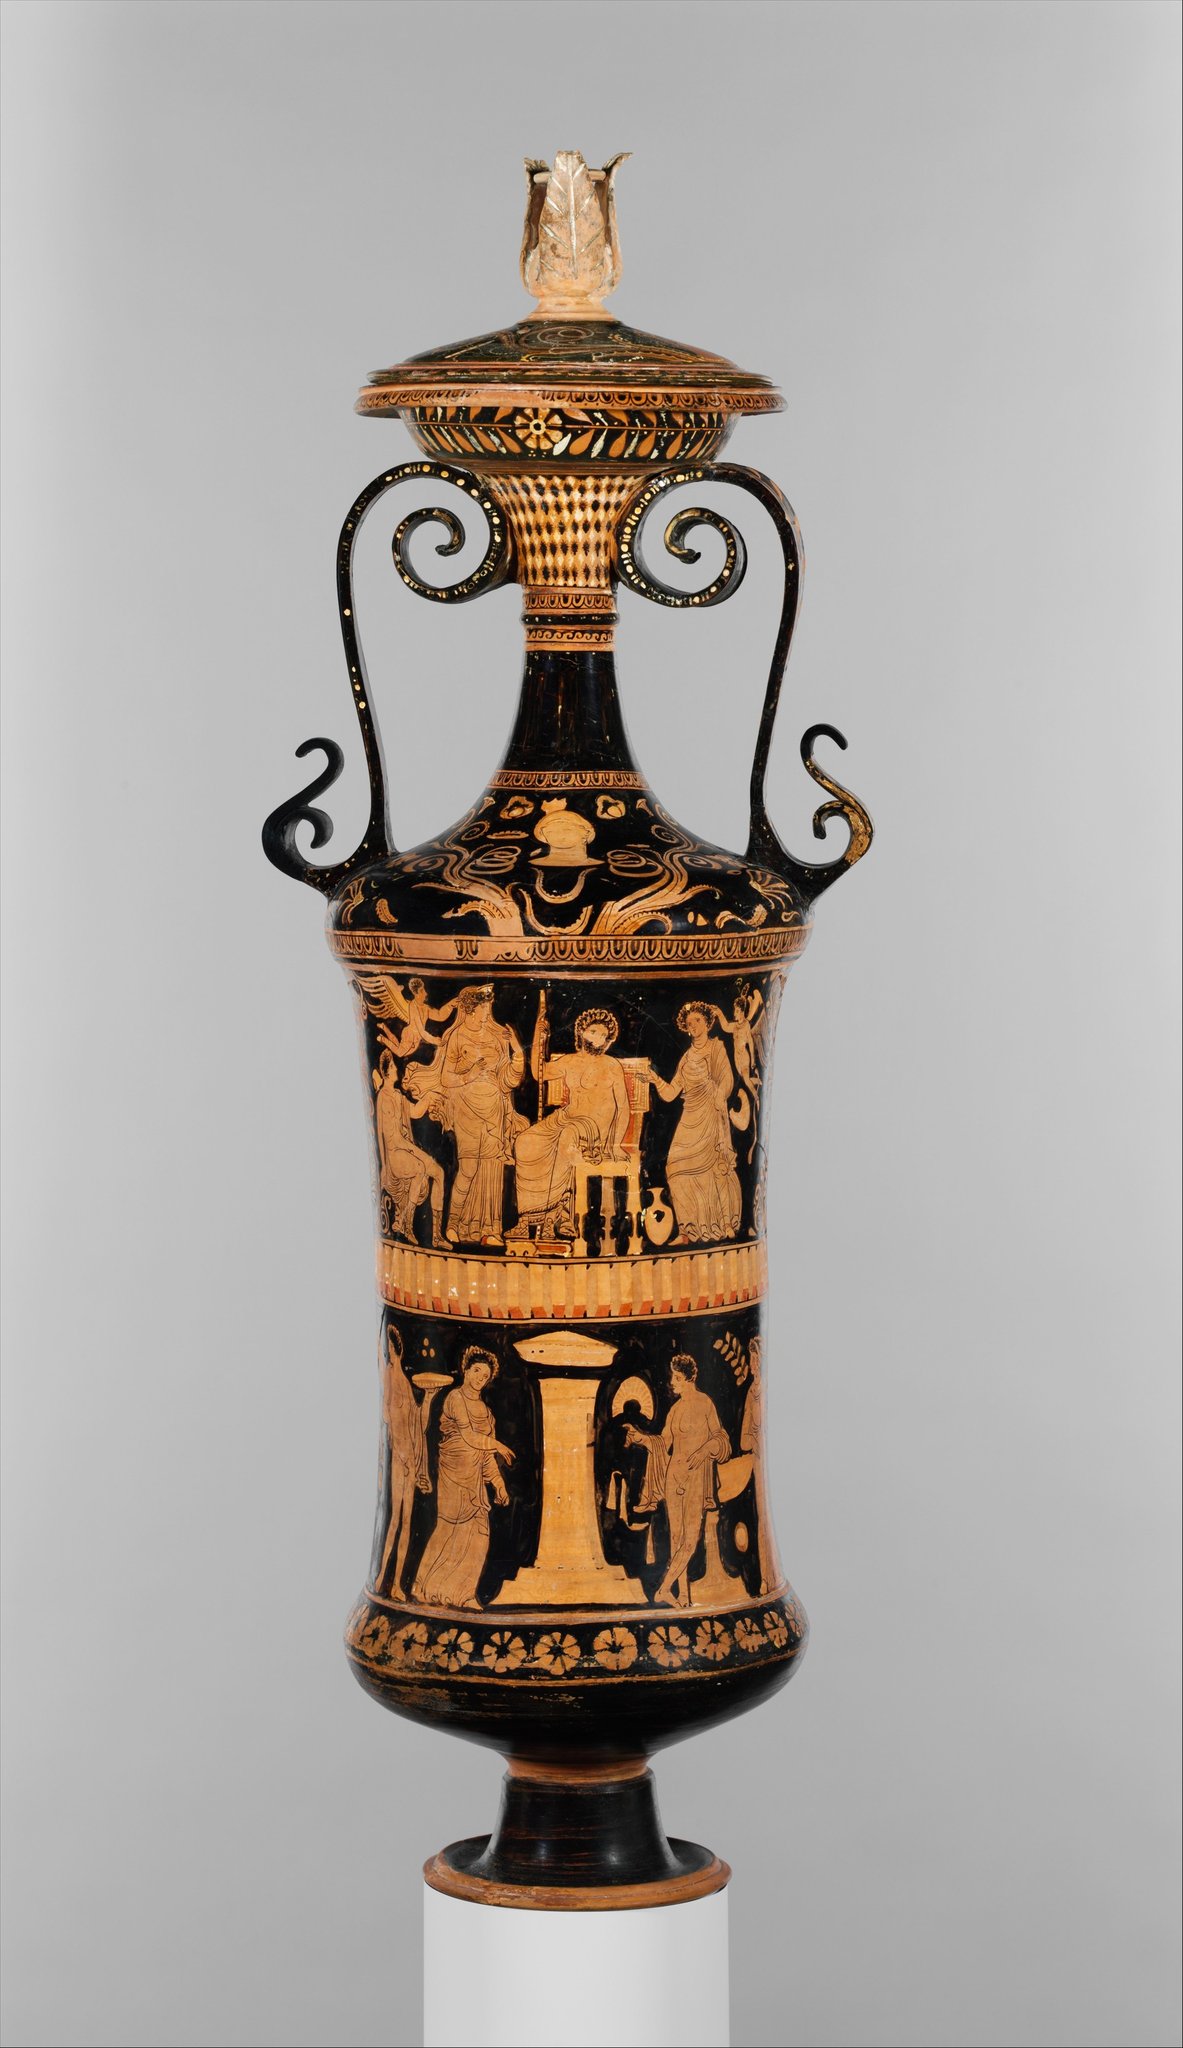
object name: loutrophoros with lid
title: Terracotta loutrophoros (ceremonial vase for water)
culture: greek, south italian, apulian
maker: darius painter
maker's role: artist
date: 340-330 BCE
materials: terracotta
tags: men,women,adonis,aphrodite,zeus,persephone,lyres